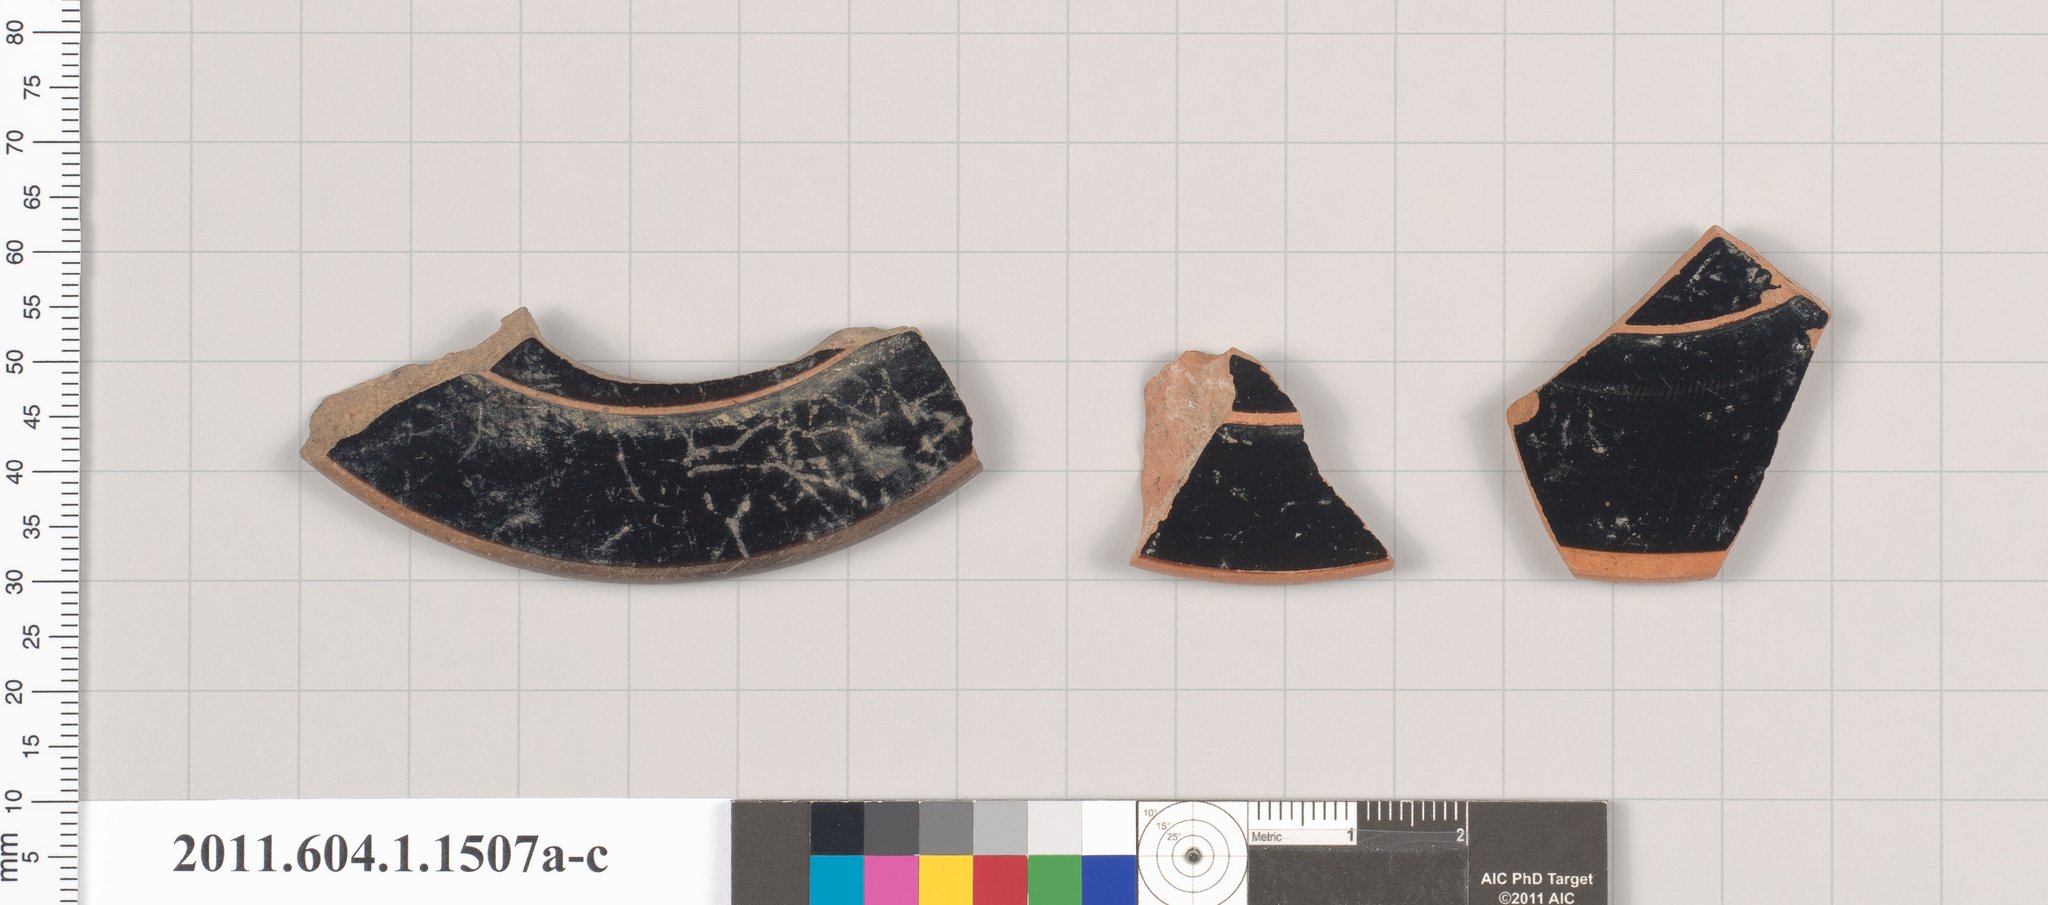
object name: kylix fragment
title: Terracotta fragments of kylikes (drinking cups)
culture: greek, attic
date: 500-401 BCE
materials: terracotta